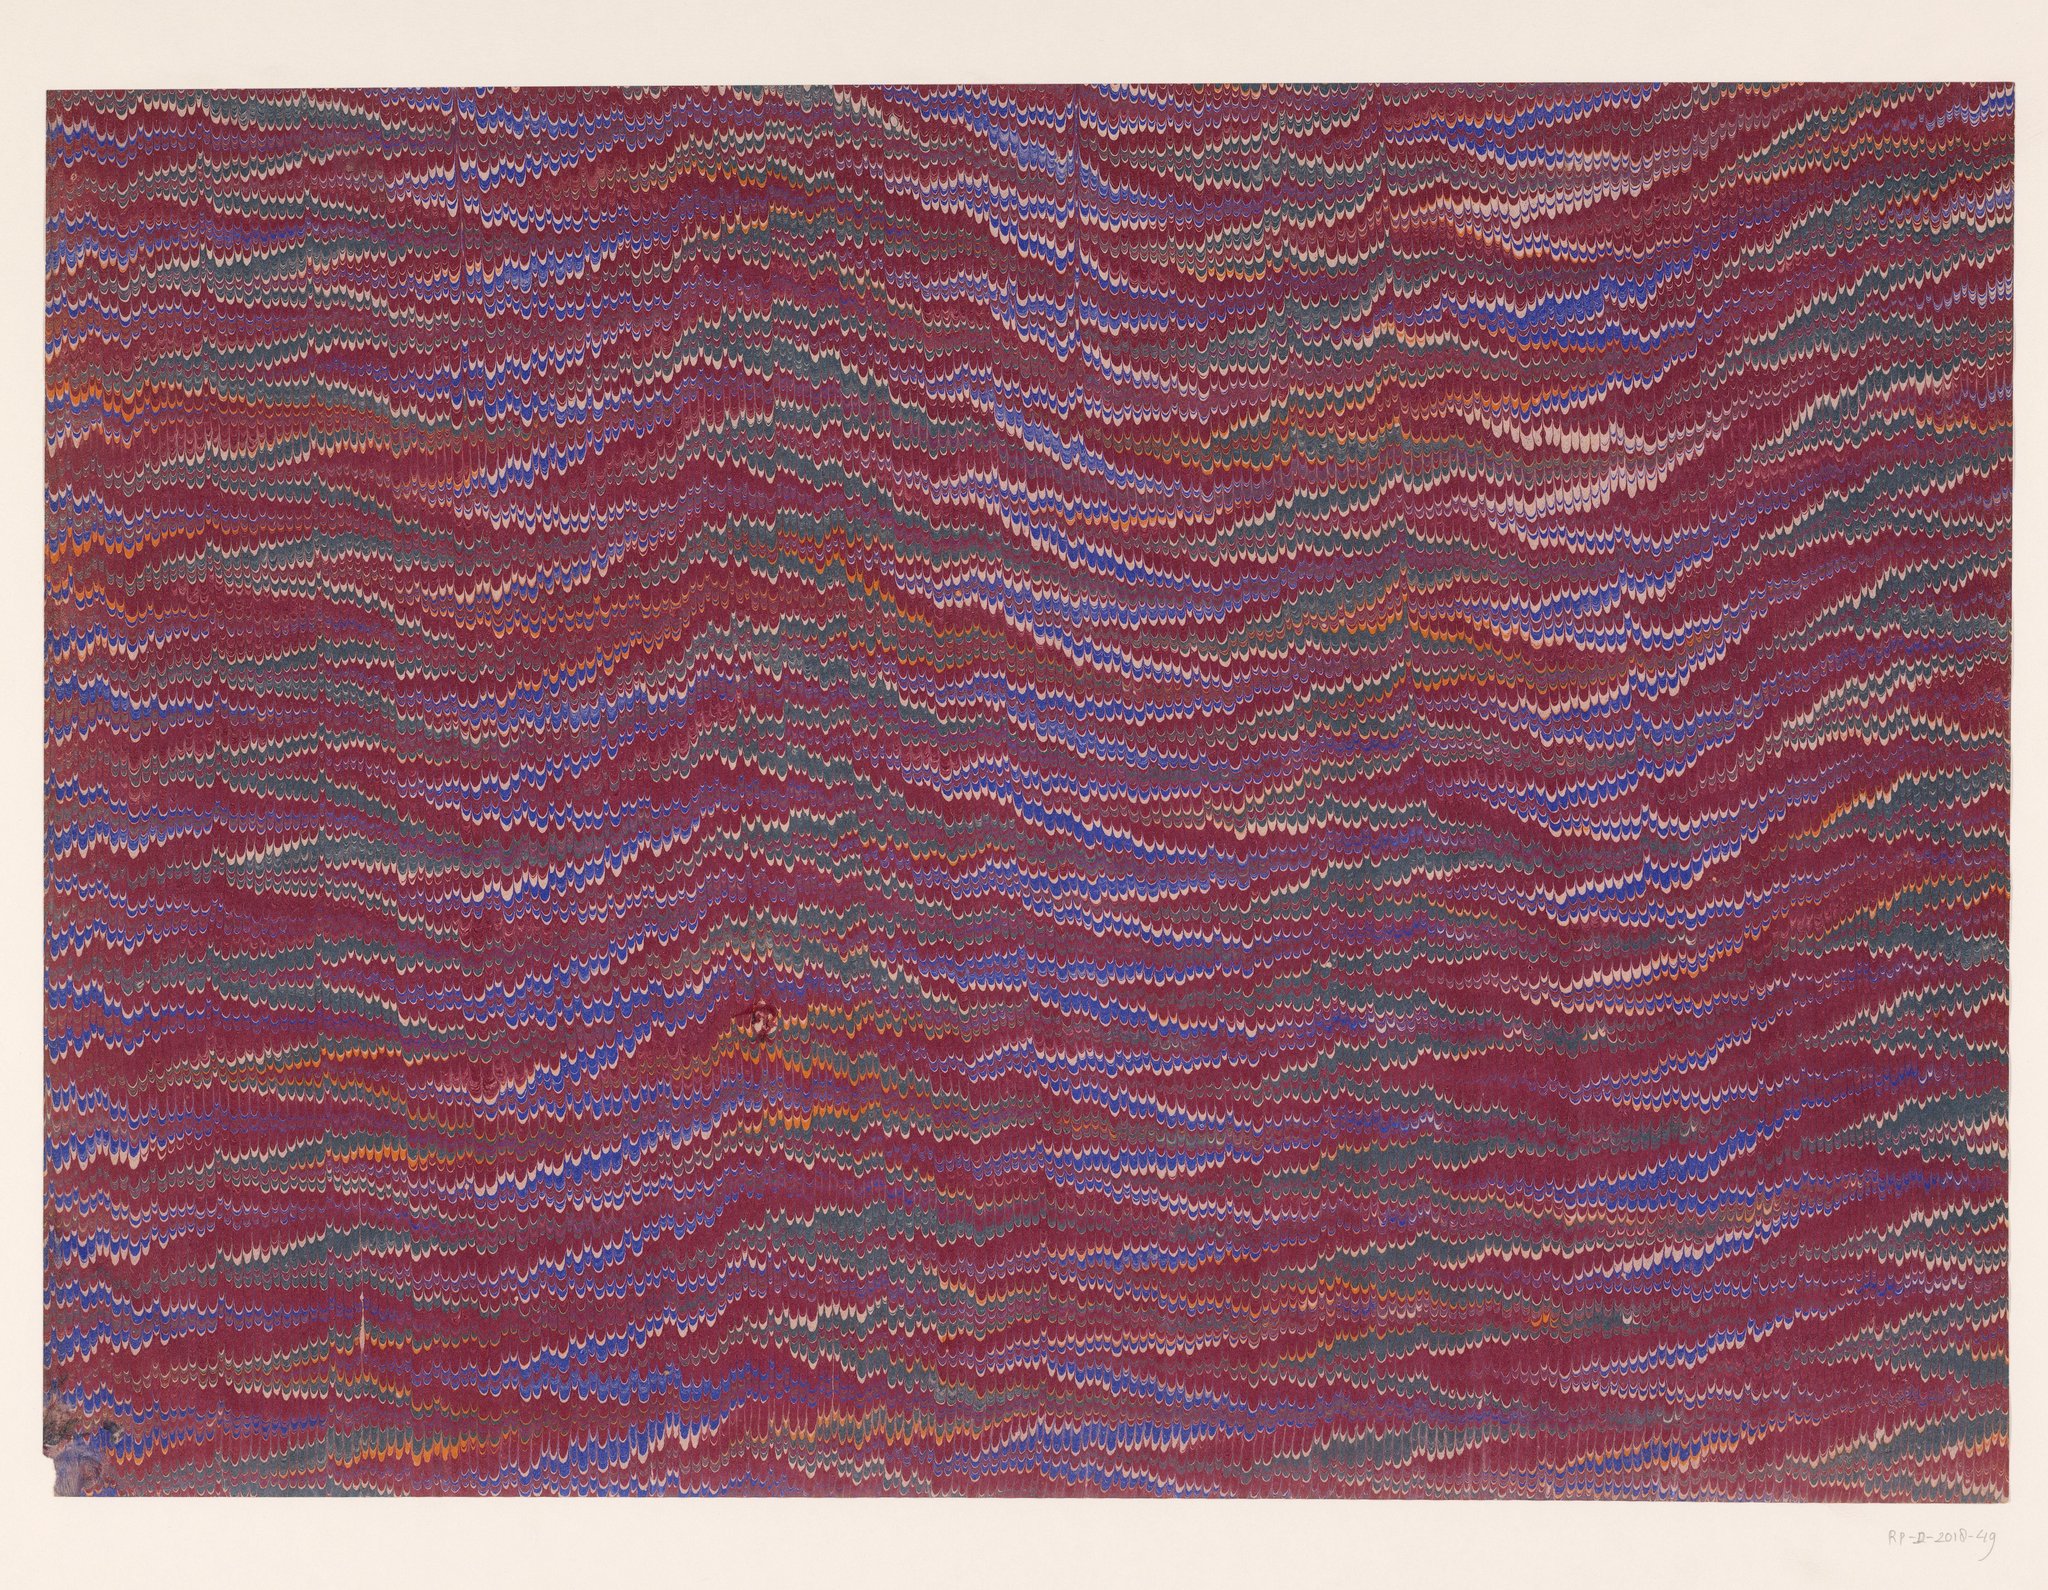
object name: marbled paper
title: Kammarmer in rood, blauw, groen en oranje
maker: Anonymous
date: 1900-2000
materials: lacquer, paint, paper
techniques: marbled paper